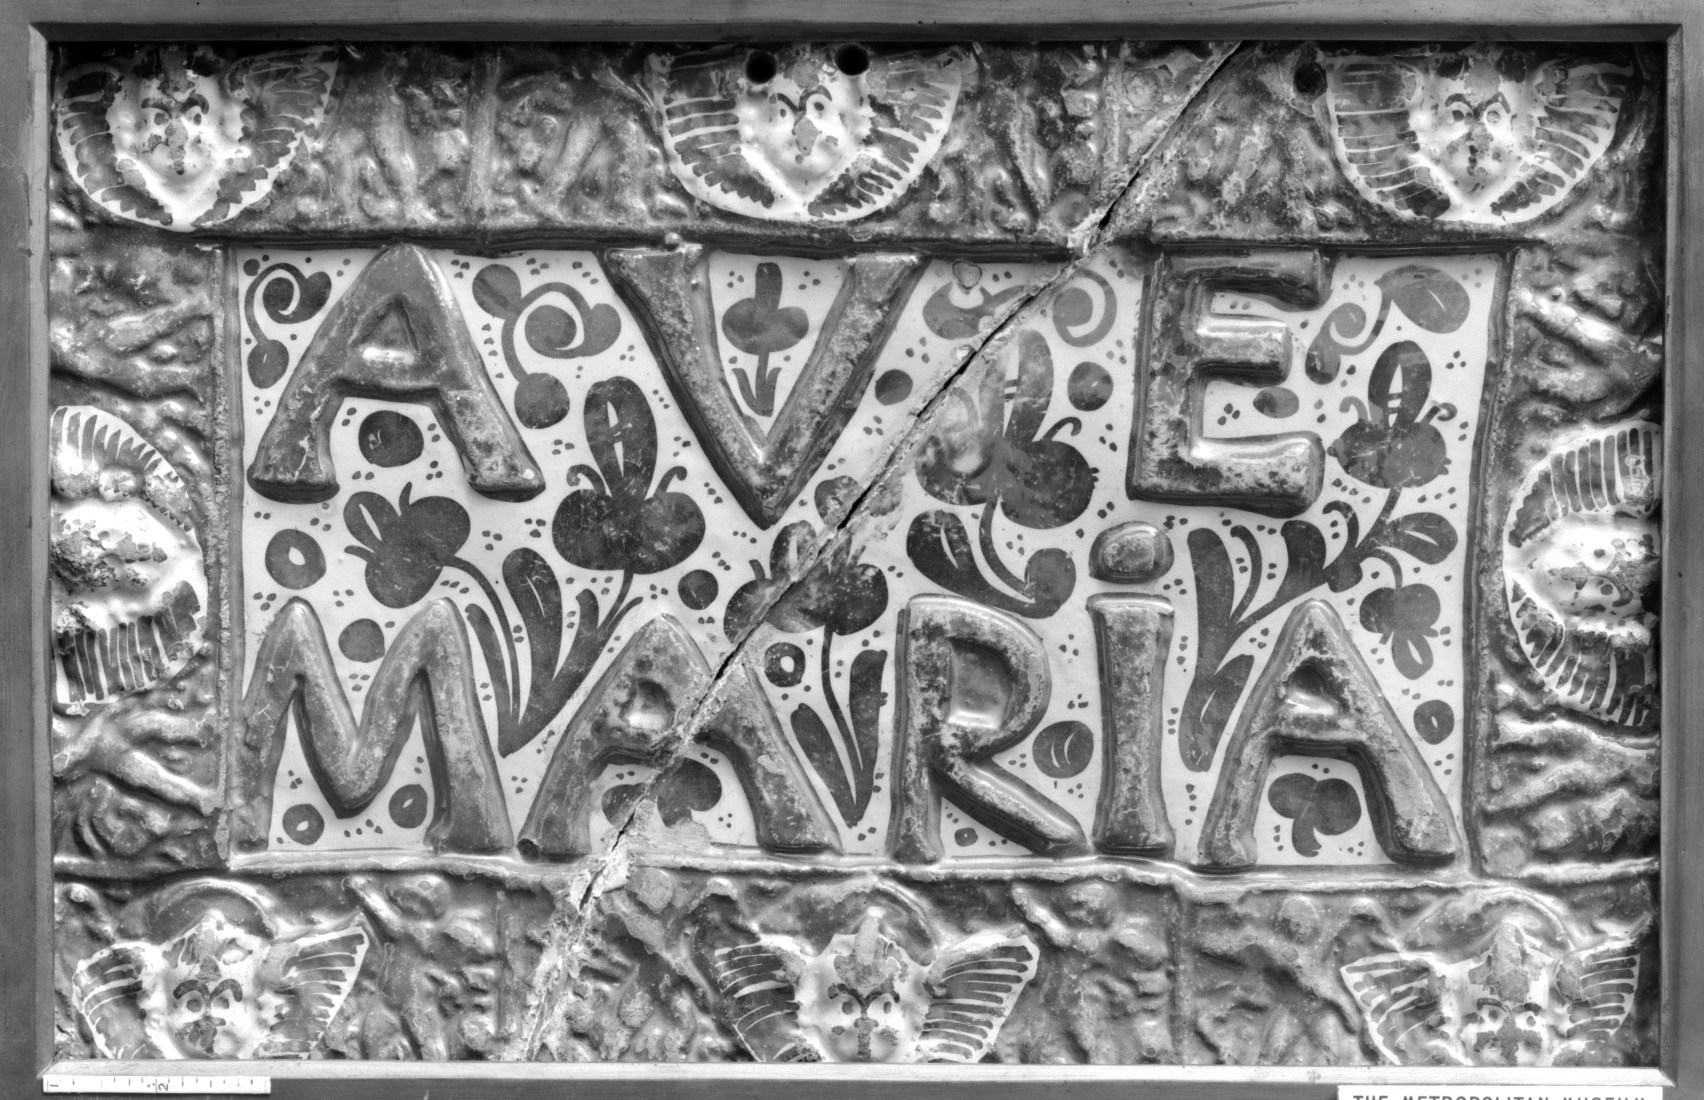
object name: wall tile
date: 1601-1800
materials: earthenware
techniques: luster painting, glazing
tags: birds,coat of arms